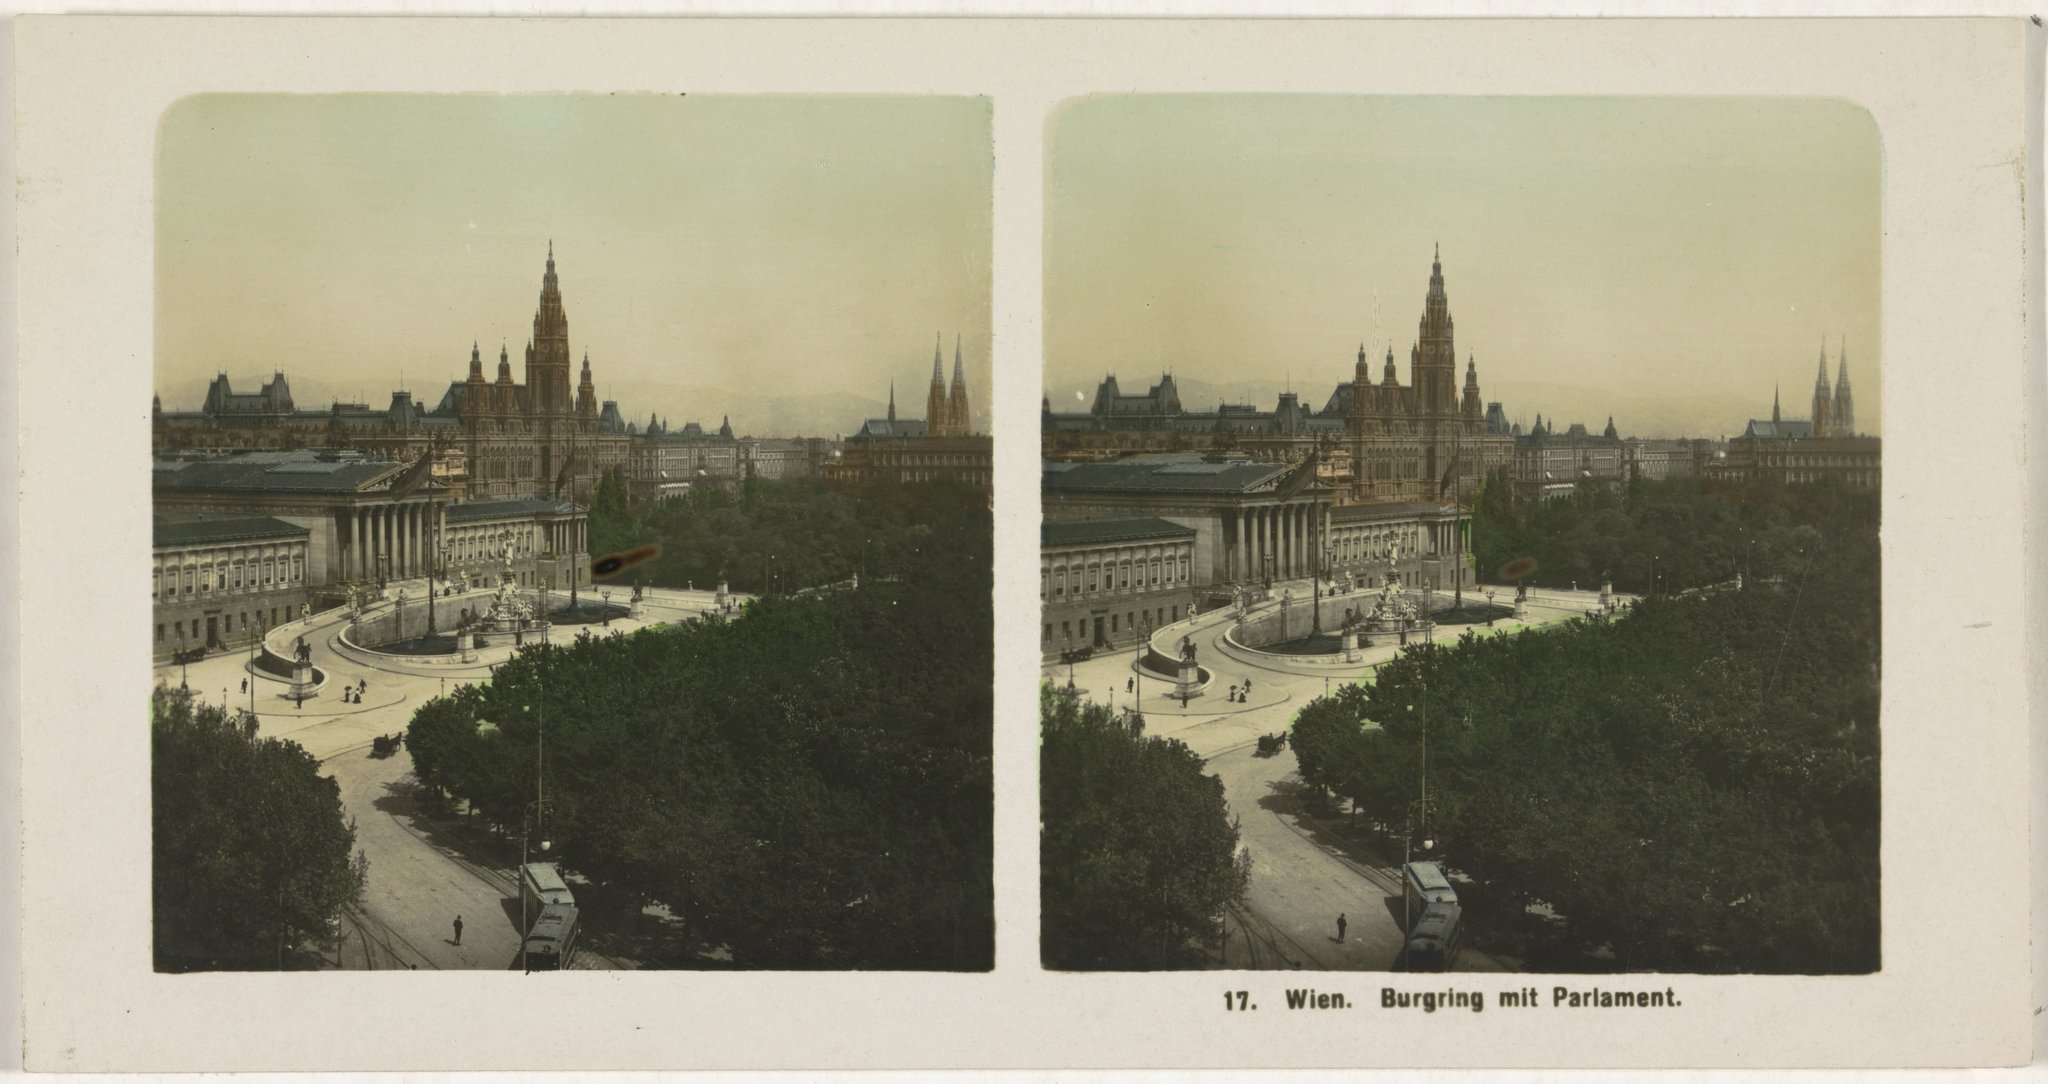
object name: stereograph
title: Burgring met het Oostenrijkse parlement en Weense stadhuis op de achtergrond, Wenen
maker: bw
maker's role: fotograaf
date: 1898-1935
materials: paper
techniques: gelatin silver print, hand coloring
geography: vienna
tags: city-view in general; 'veduta', vienna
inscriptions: monogram: ‘BW’, inscription: ‘Oesterreich. Wien. Burgring mit Parlament./ Austria. Vienna "Burgring" with Parliament./ Autriche. Vienne. "Burgring" et Parlement./ Austria. Viena. "Burgring" y Parlamento.’, number: ‘17.’